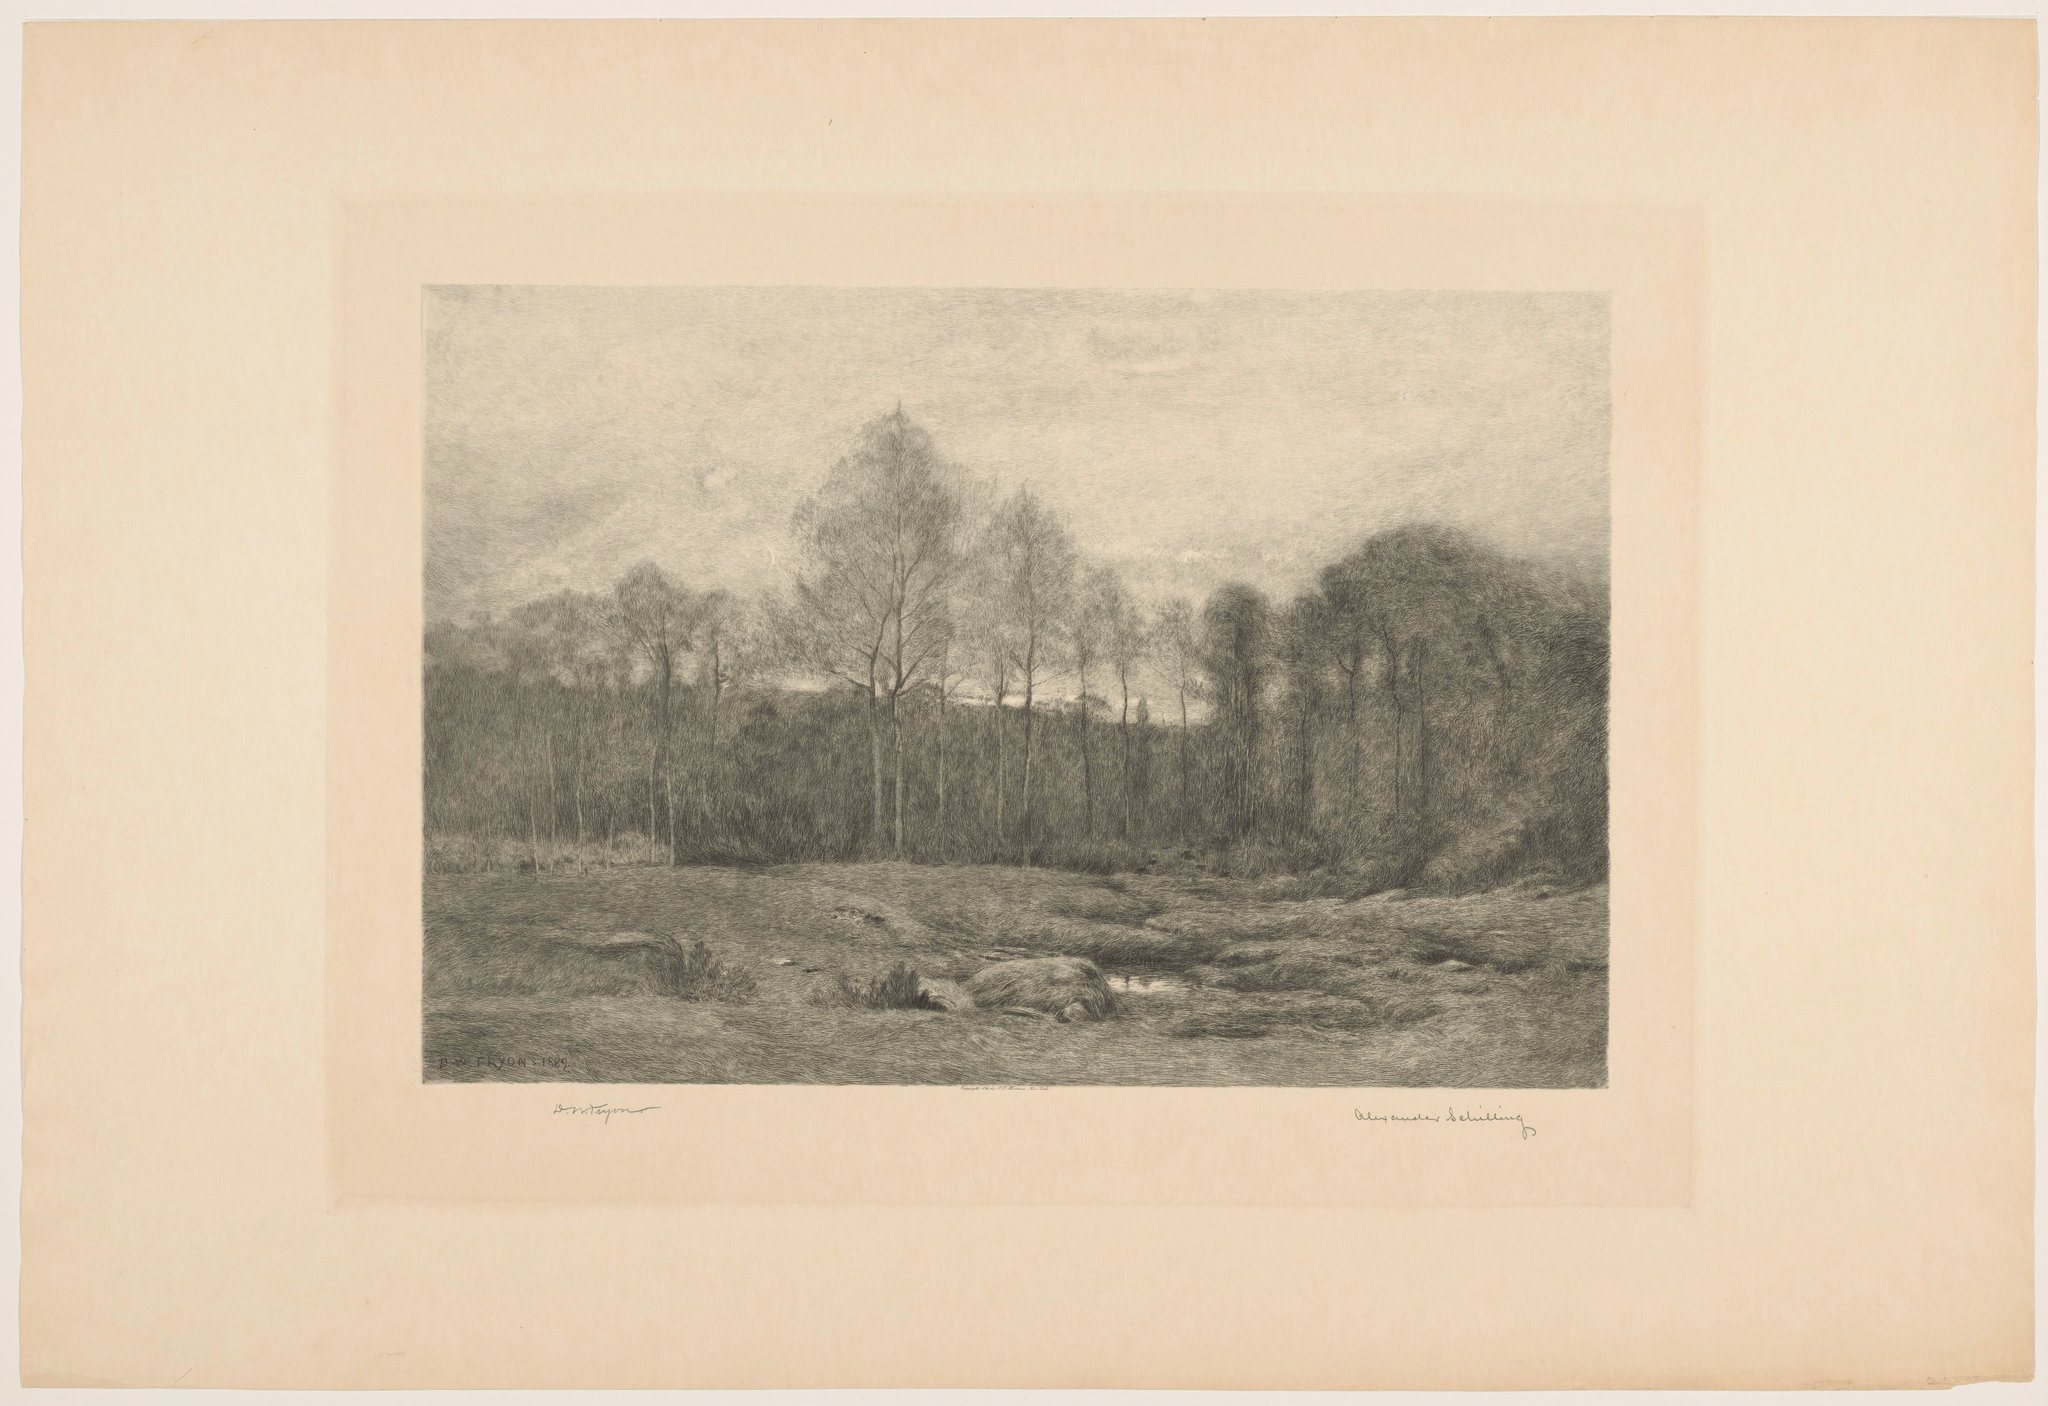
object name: print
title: Bosrijk landschap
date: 1819-1891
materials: paper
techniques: drypoint, etching, intaglio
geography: england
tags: trees, landscapes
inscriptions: collector's mark: Lugt 2228, inscription: ‘Geschenk van den Heer. K.H. de Haas / te Rotterdam’